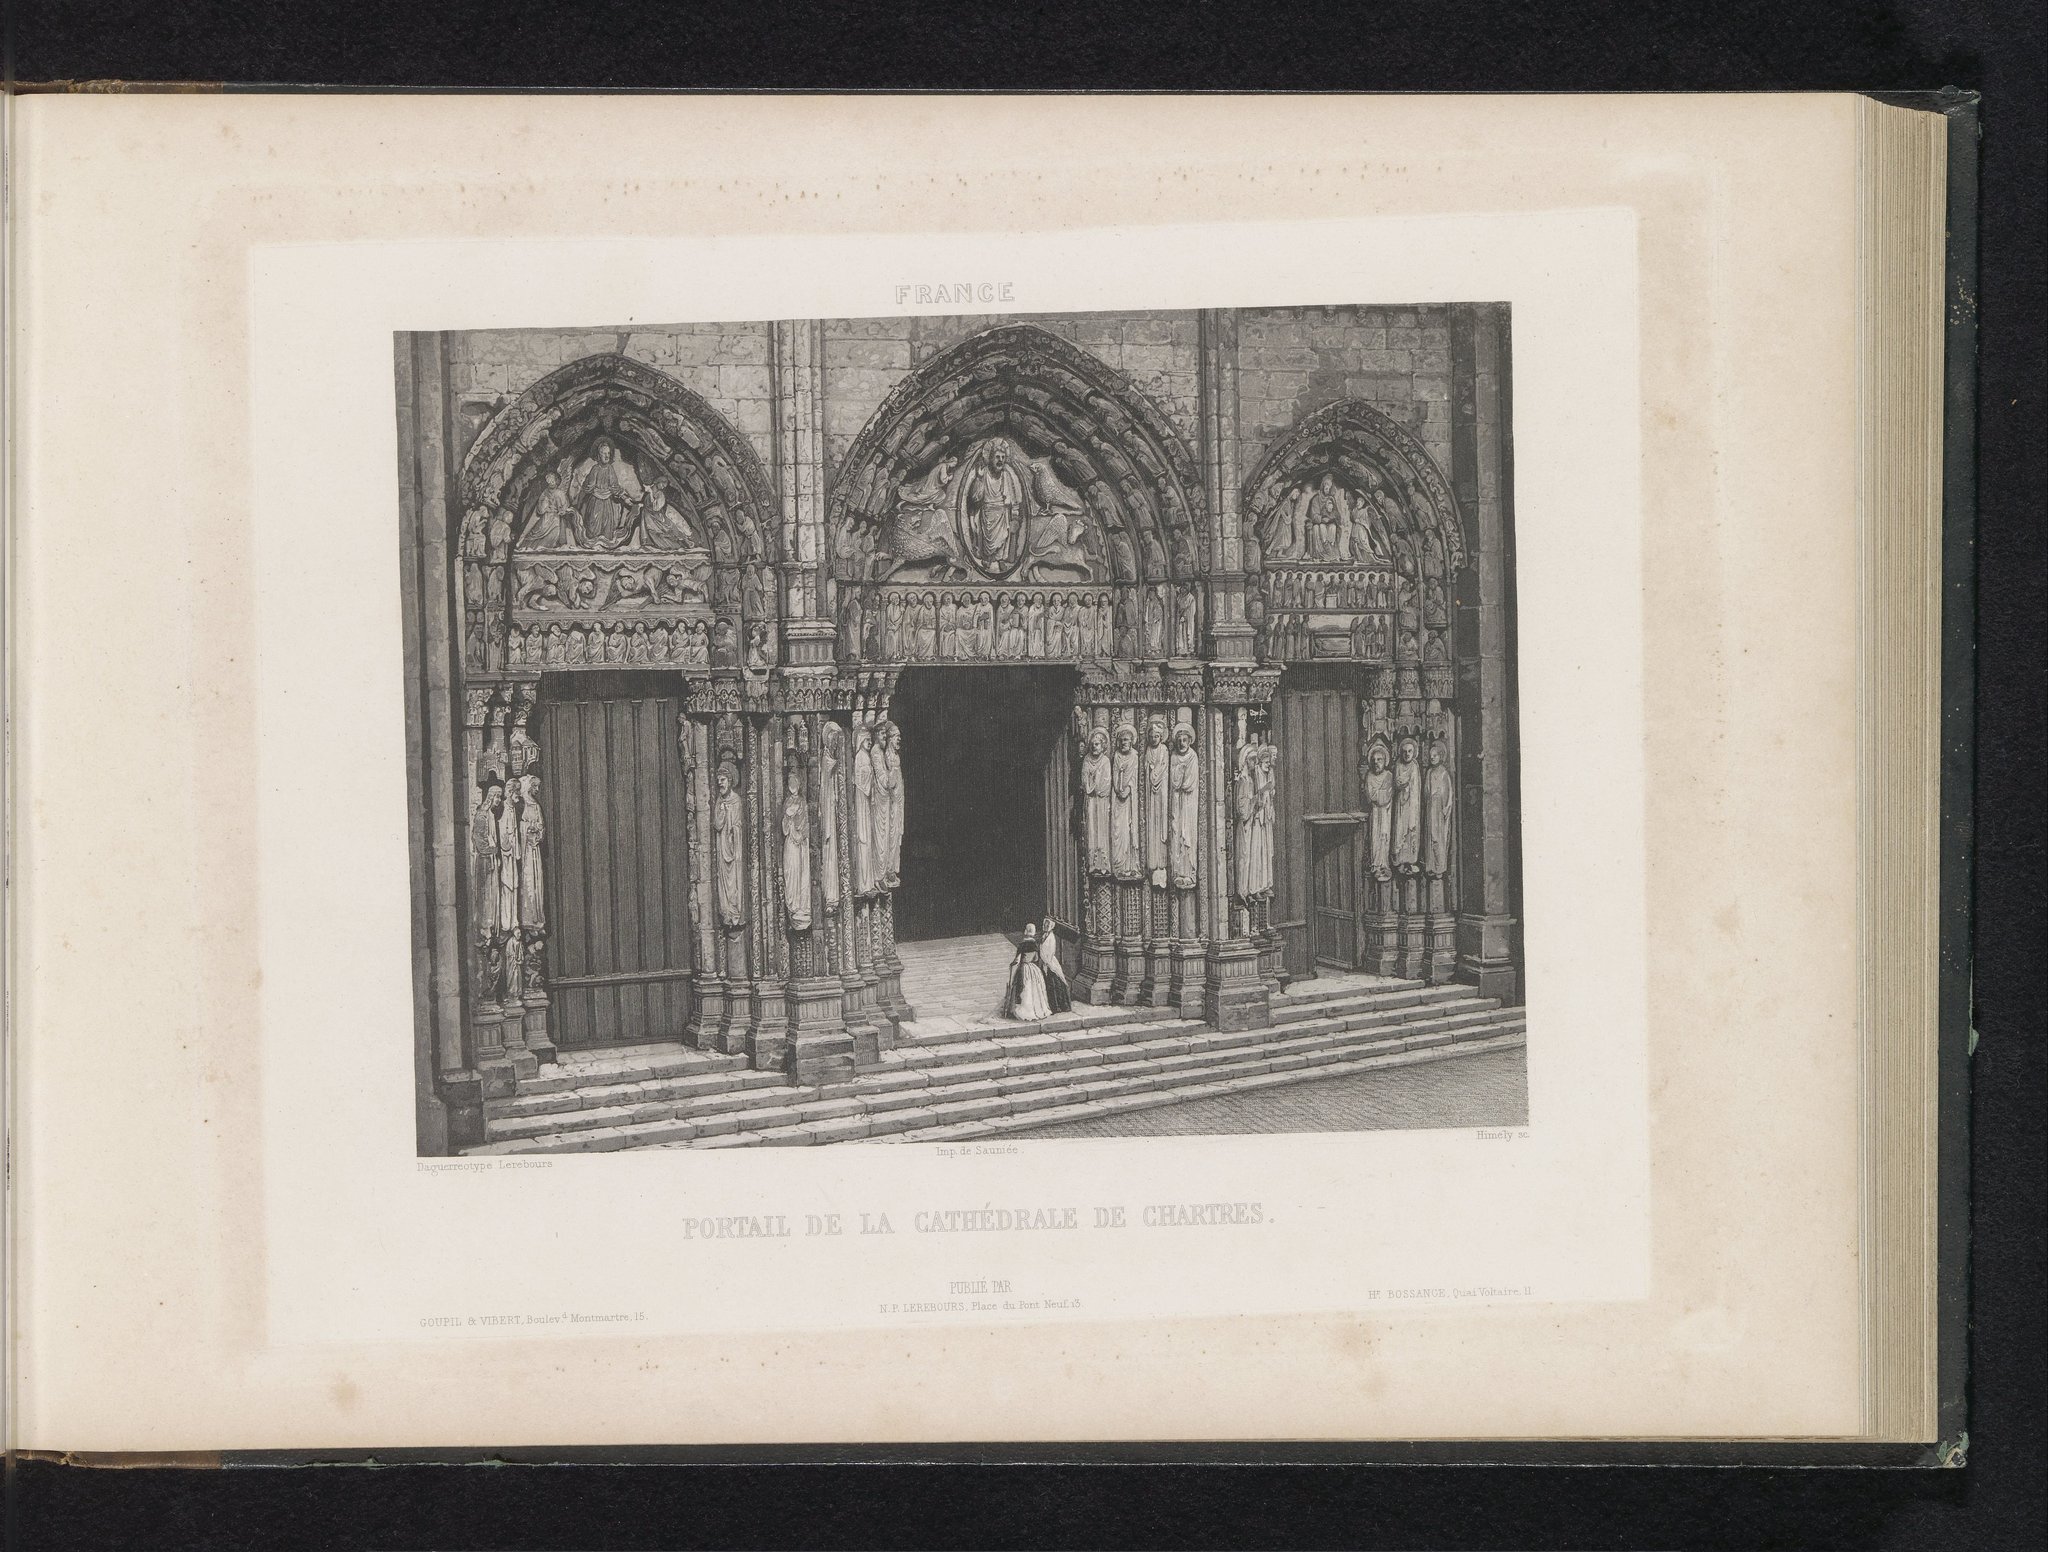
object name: print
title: France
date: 1839-1841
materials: paper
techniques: aquatint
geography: paris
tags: parts of church exterior and annexes: portal, façade (of house or building)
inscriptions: inscription: ‘Hr. Bossance Quai Voltaire 11’, inscription: ‘N.P. Lerebours Place du Pont Neuf 15’, inscription: ‘Rittner & Goupil Boulevd Montmartre 15’